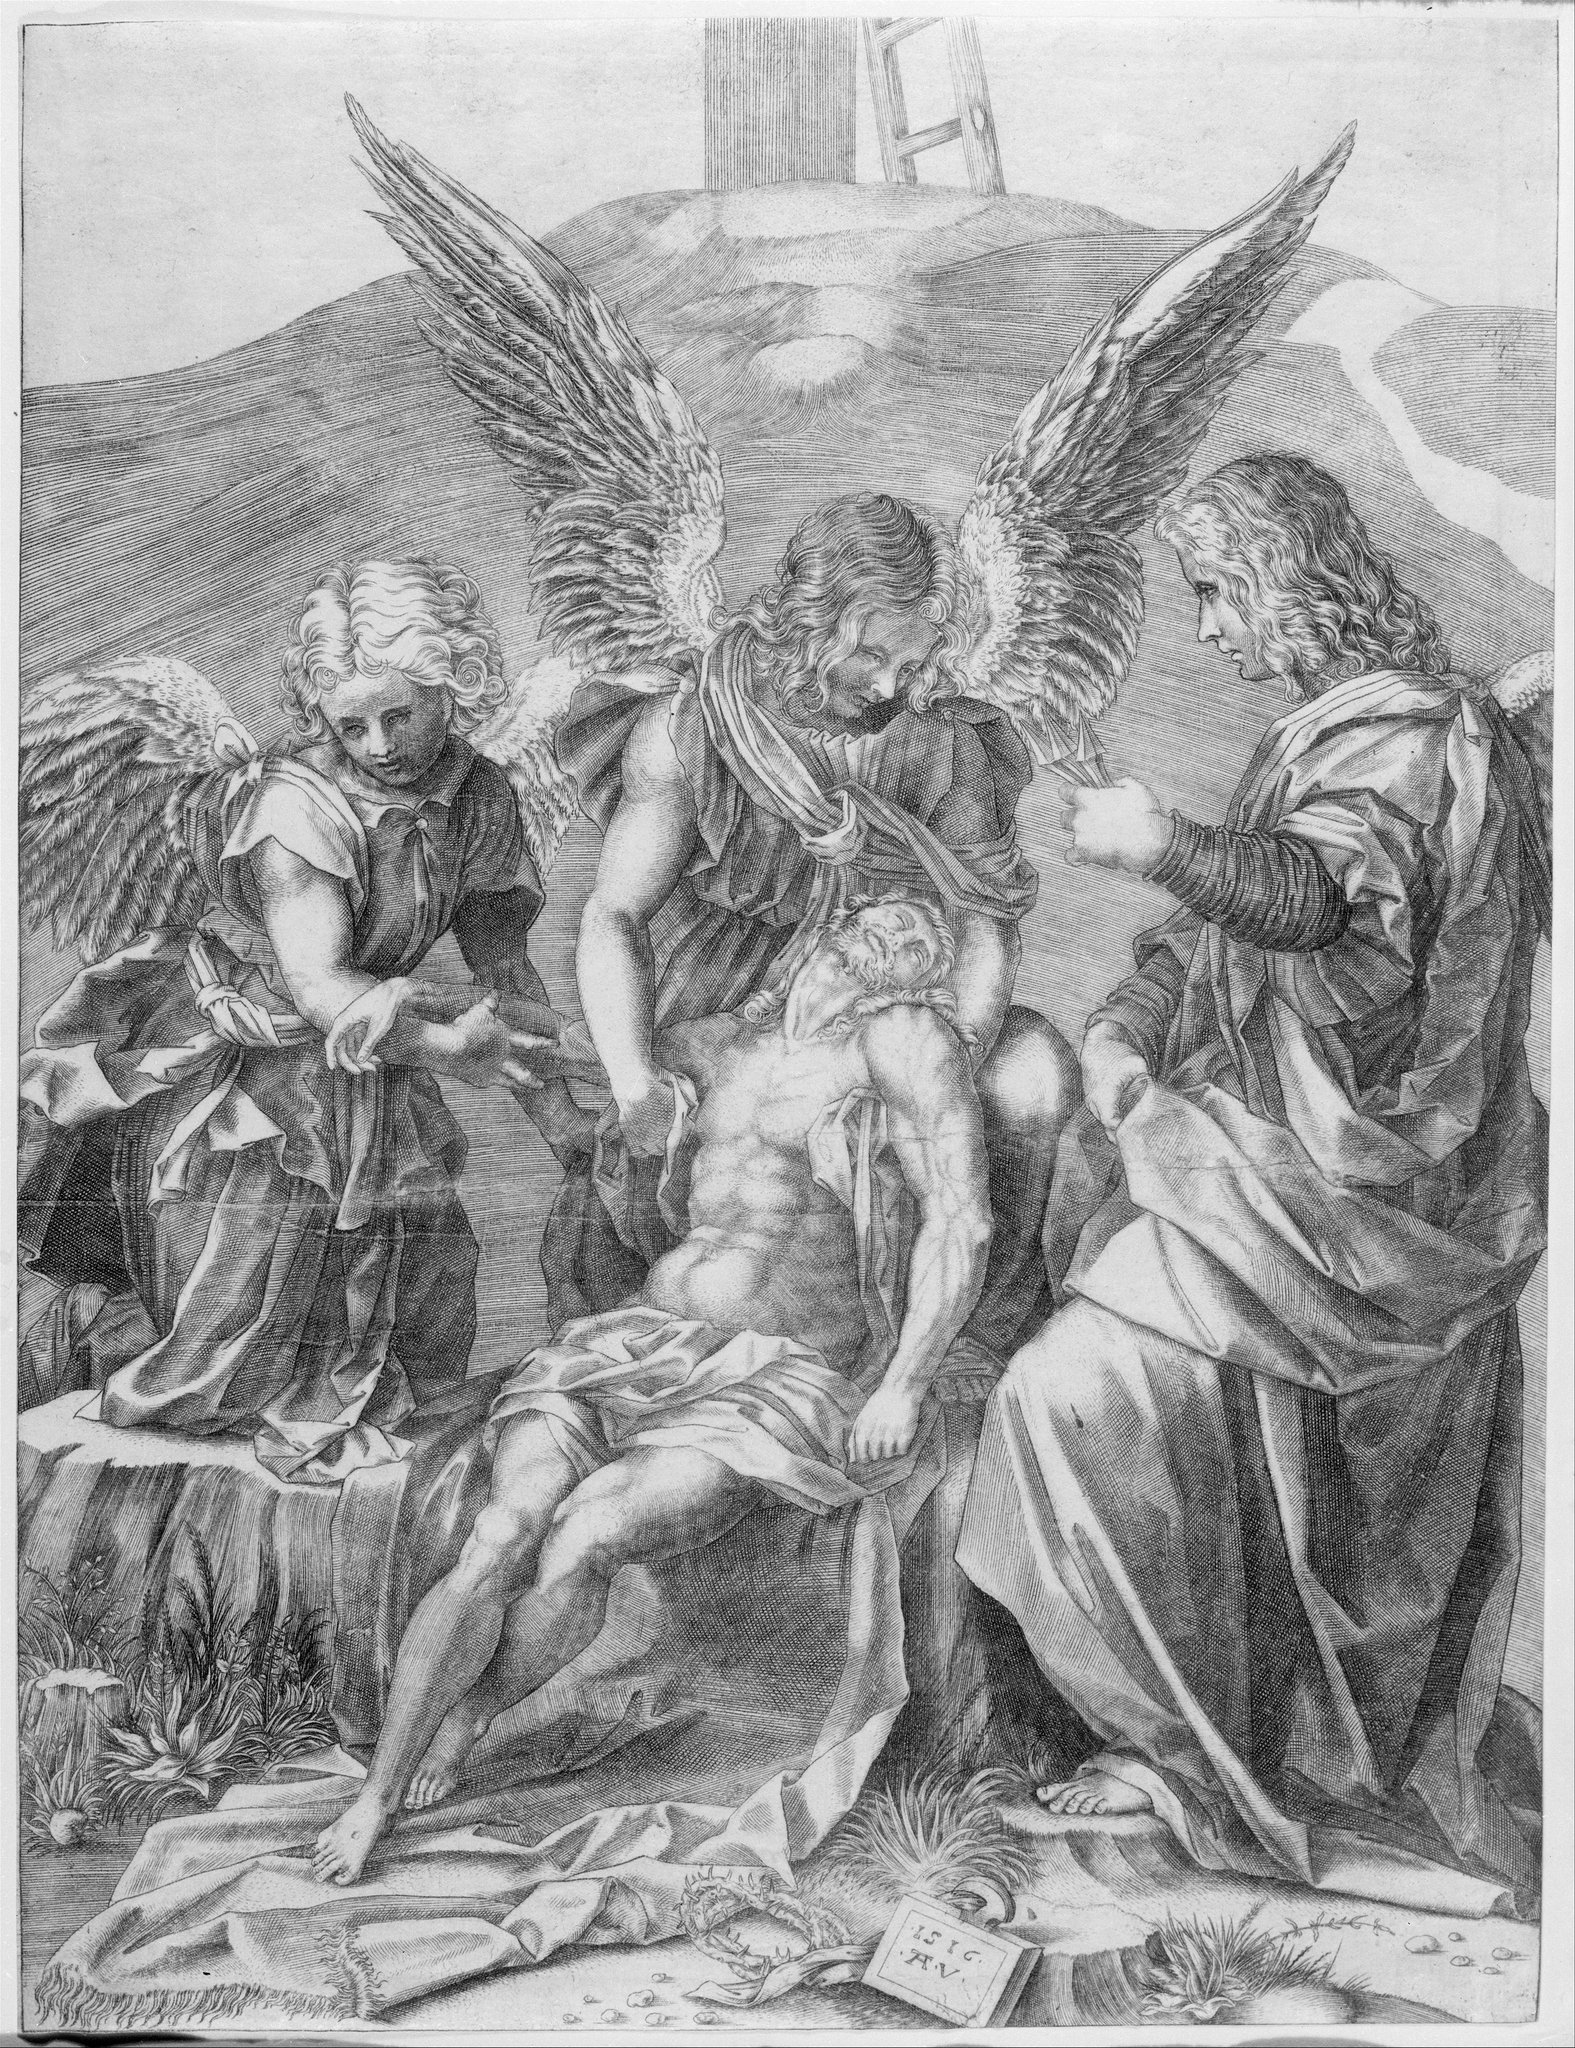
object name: print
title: The Body of Christ Supported by Three Angels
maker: agostino veneziano (agostino dei musi)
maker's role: artist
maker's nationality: italian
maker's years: 1490-1536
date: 1516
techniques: engraving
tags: angels,christ